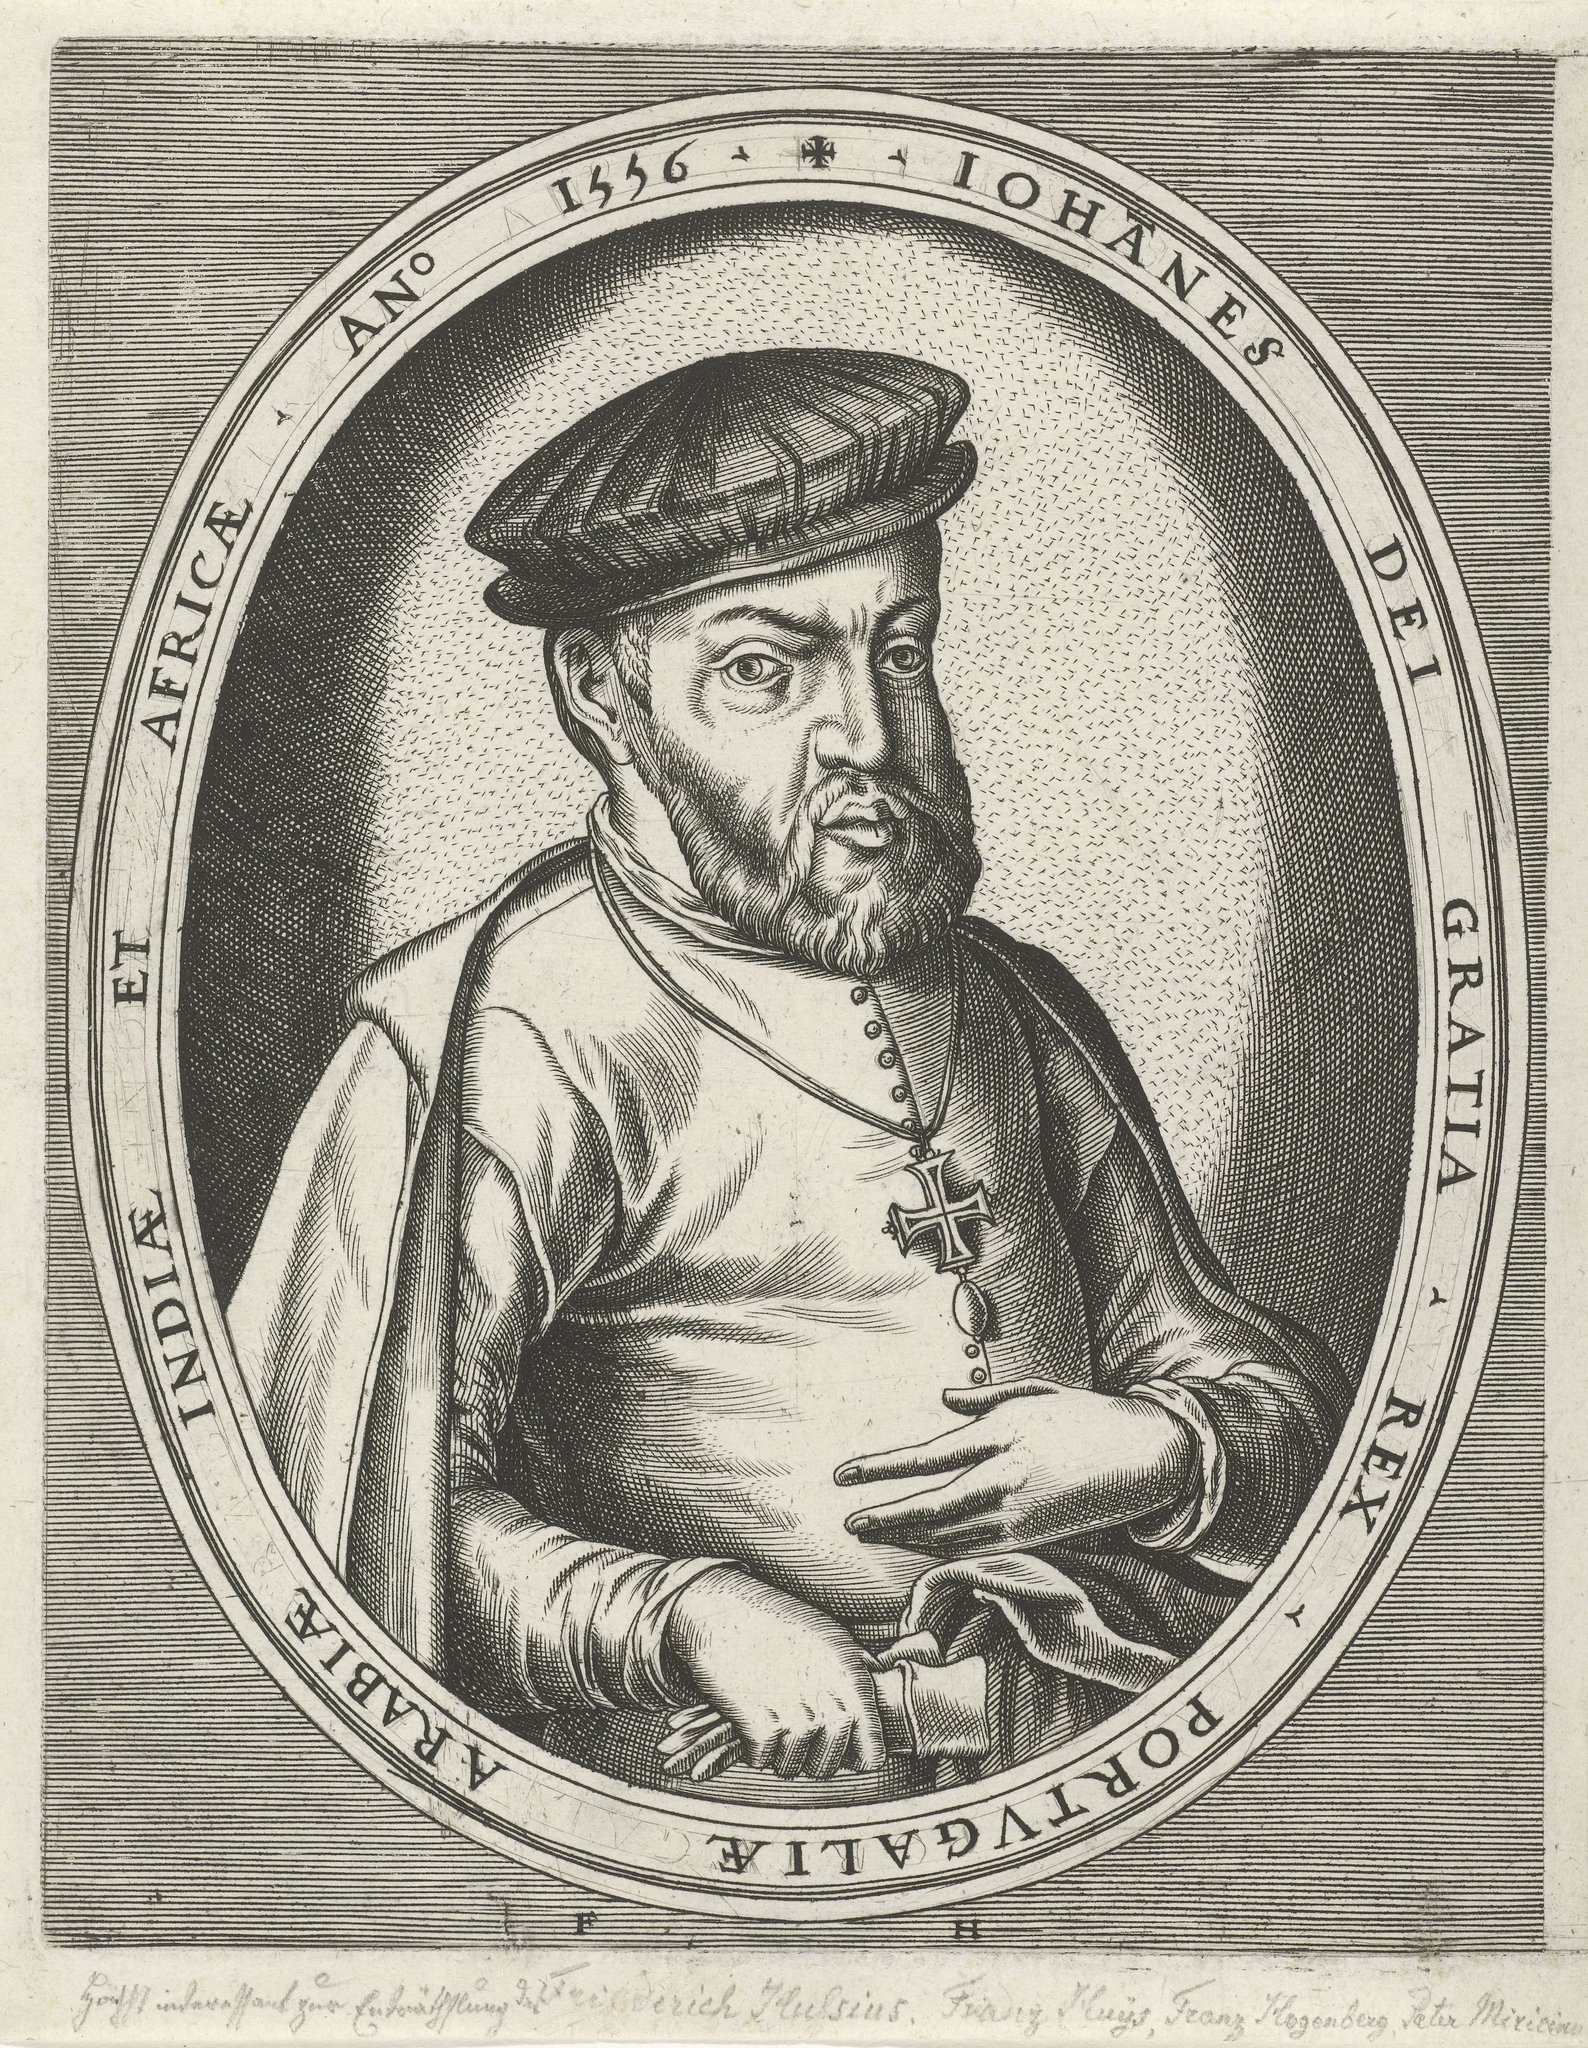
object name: print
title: Portretten van koningen, koninginnen, prinsen en prinsessen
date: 1556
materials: paper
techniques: engraving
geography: antwerp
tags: koning, johannes iii (koning van portugal)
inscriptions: collector's mark: Lugt 845, collector's mark: Lugt 2228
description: Johannes III, koning van Portugal, ten halven lijve naar rechts, met een paar handschoenen in zijn rechterhand. Portret in ovale lijst met randschrift in het Latijn.